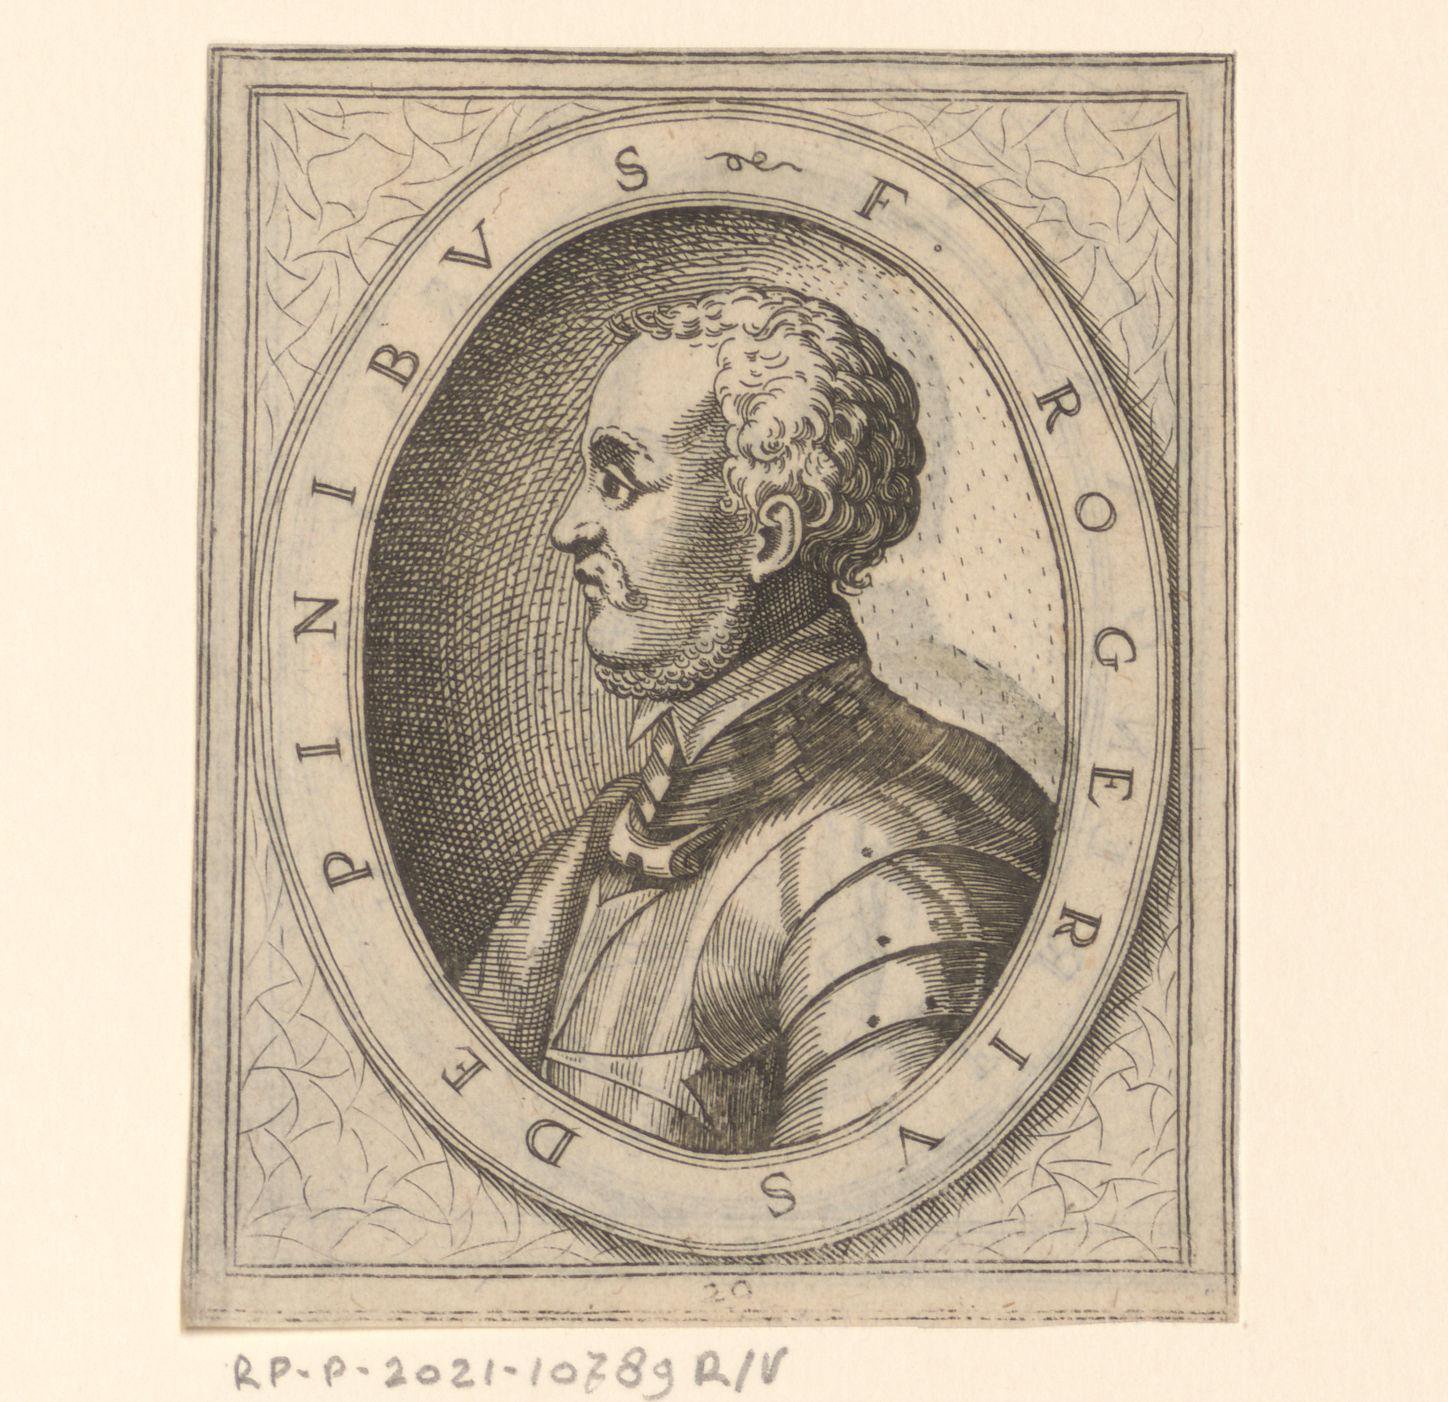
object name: print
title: Portret van Roger de Pins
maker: Anonymous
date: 1643-1659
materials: paper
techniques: engraving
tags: historical persons, military orders, e.g.: knights templars, knights of malta, teutonic knights ~ roman catholic church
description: Prent mogelijk uit: Baudoin, Jean. Histoire des chevaliers de l'ordre de s. Jean de Hierusalem (...). Parijs: Jacques Dallin, 1643. Of uit: Baudoin, Jean. Histoire des chevaliers de l'ordre de s. Jean de Hierusalem (...). Parijs: Thomas Jolly, 1659.